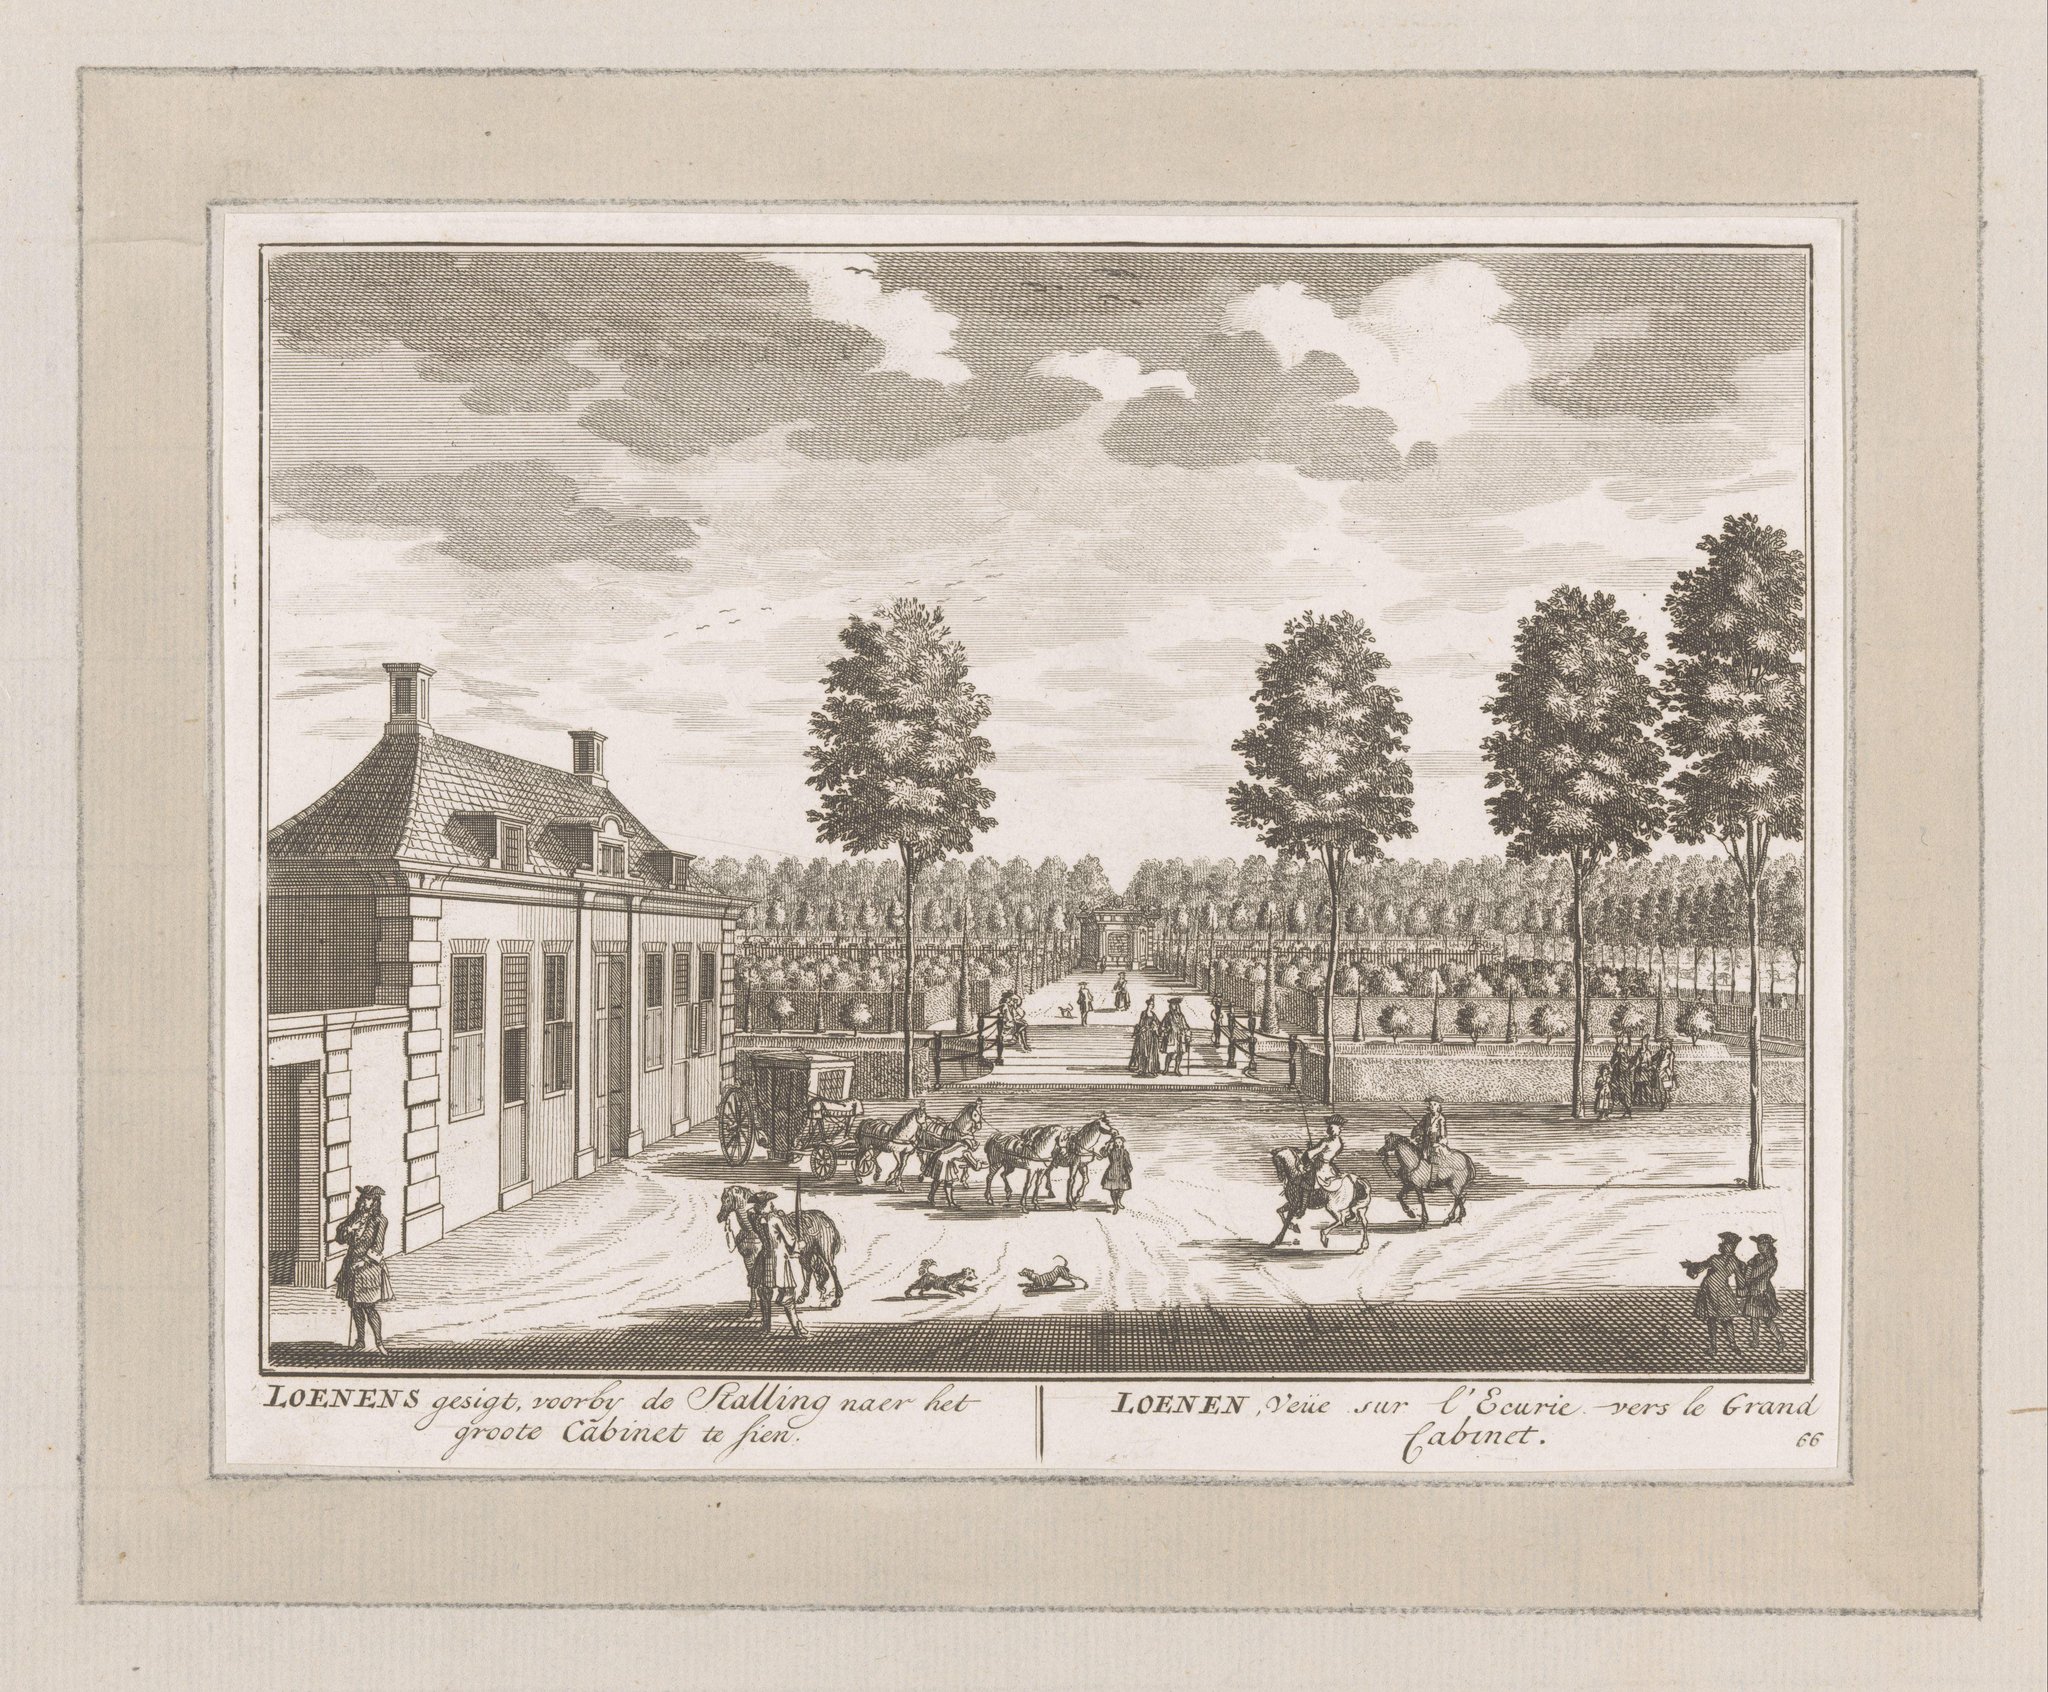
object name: print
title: Gezicht op de stallen van huis Loenen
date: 1719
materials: paper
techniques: etching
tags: rural housing, e.g. country-house, villa, cottage, stall, stable, vecht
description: Prent uit: De zegepraalende Vecht, vertoonende verscheidene gesichten van lustplaatsen, heeren huysen en dorpen, beginnende van Uitrecht en met Muyden besluytende. Amsterdam: Wed. Nicolaes Visscher, 1719.